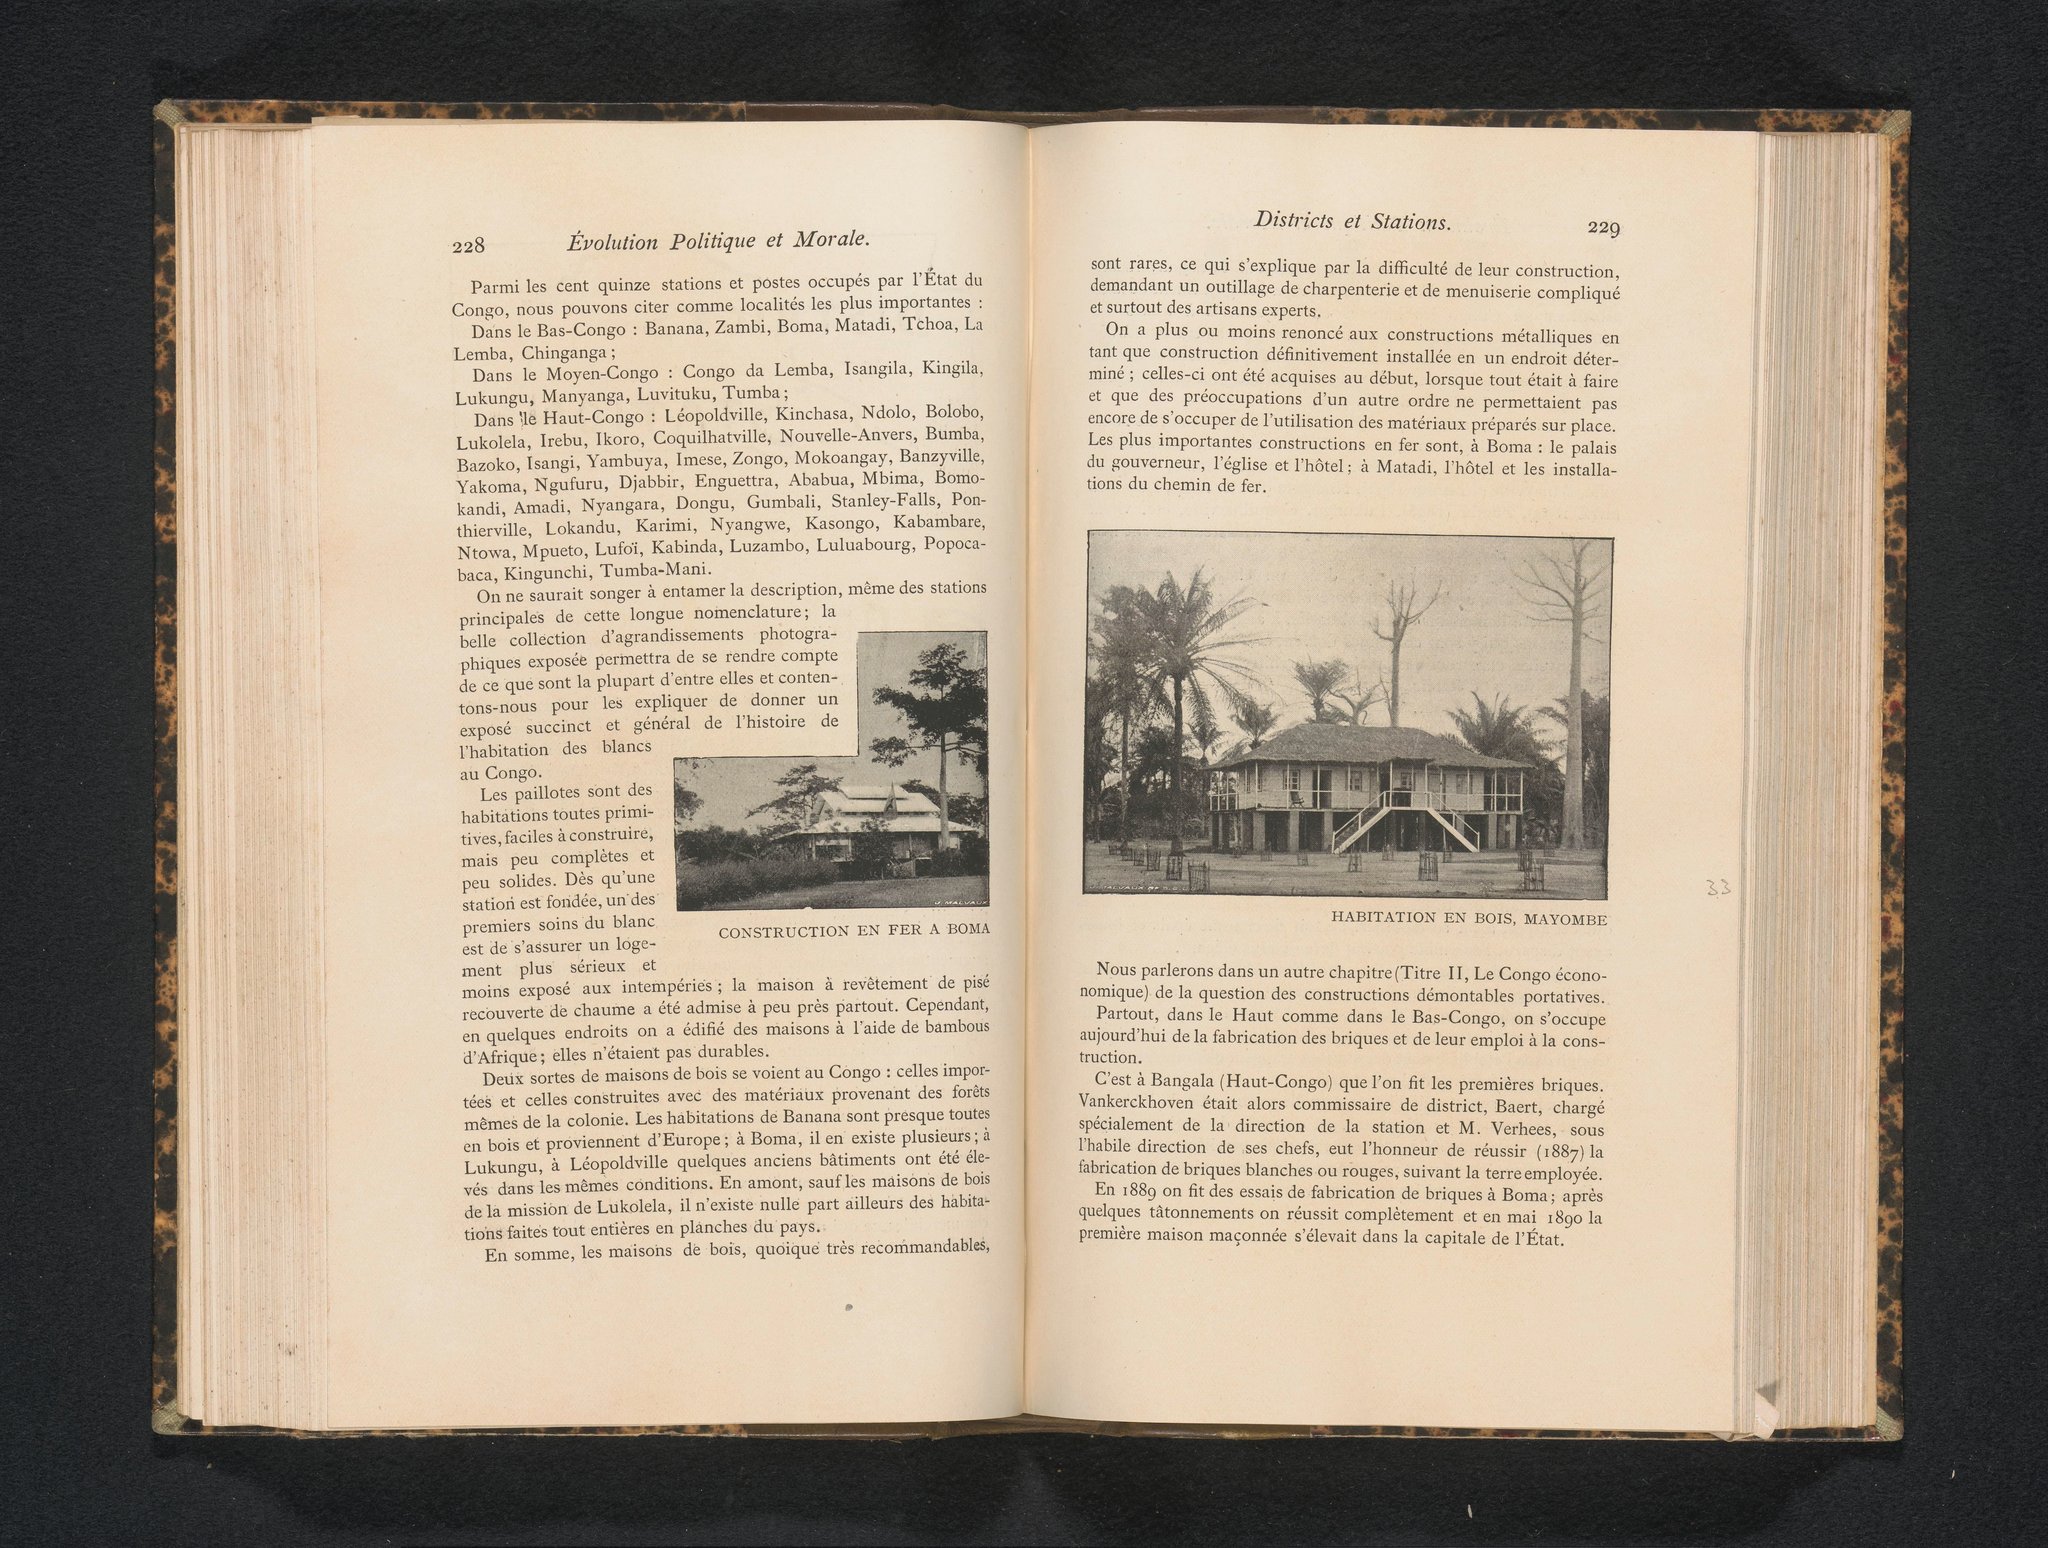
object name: photomechanical print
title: Gezicht op een houten huis in Mayombe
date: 1887-1892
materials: paper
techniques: autotype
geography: congo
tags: façade (of house or building)